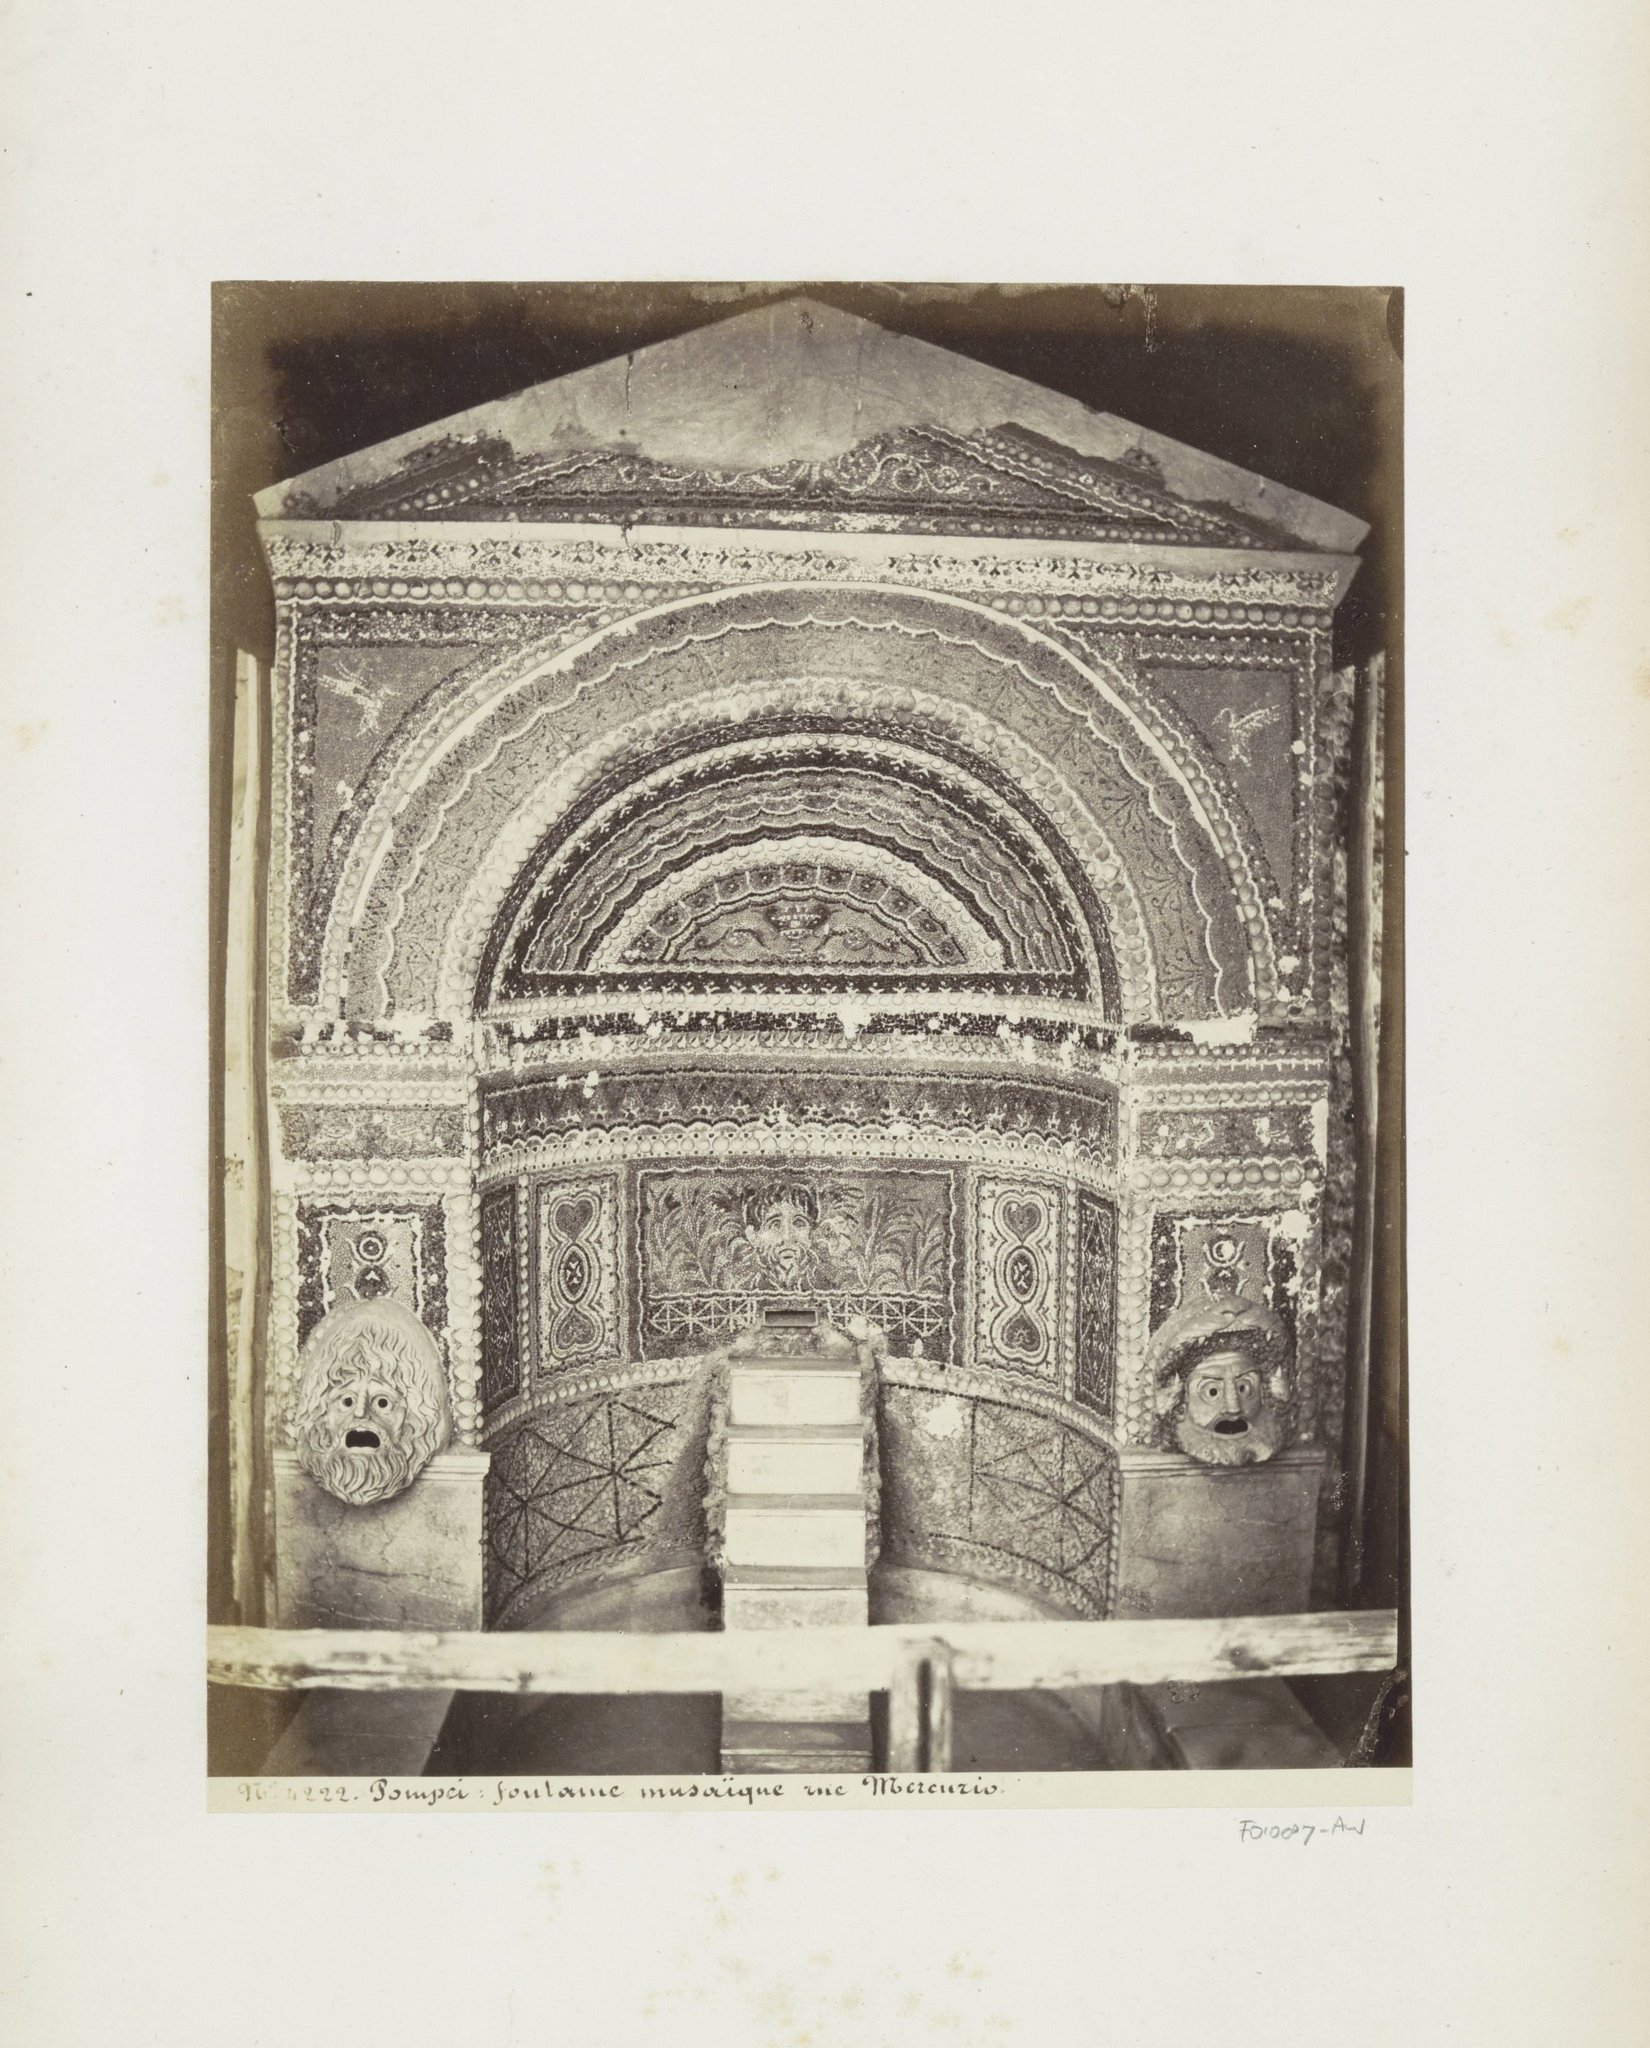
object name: photograph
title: Mozaïek met fontein in de Straat van Mercurius in Pompeï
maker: Anonymous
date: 1865-1875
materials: paper, photographic support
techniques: albumen print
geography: pompeii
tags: ornamental fountain, excavation ~ archaeology, pompeii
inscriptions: negative number: ‘4222’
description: Onderdeel van Reisalbum met foto's van bezienswaardigheden in Napels en omgeving.